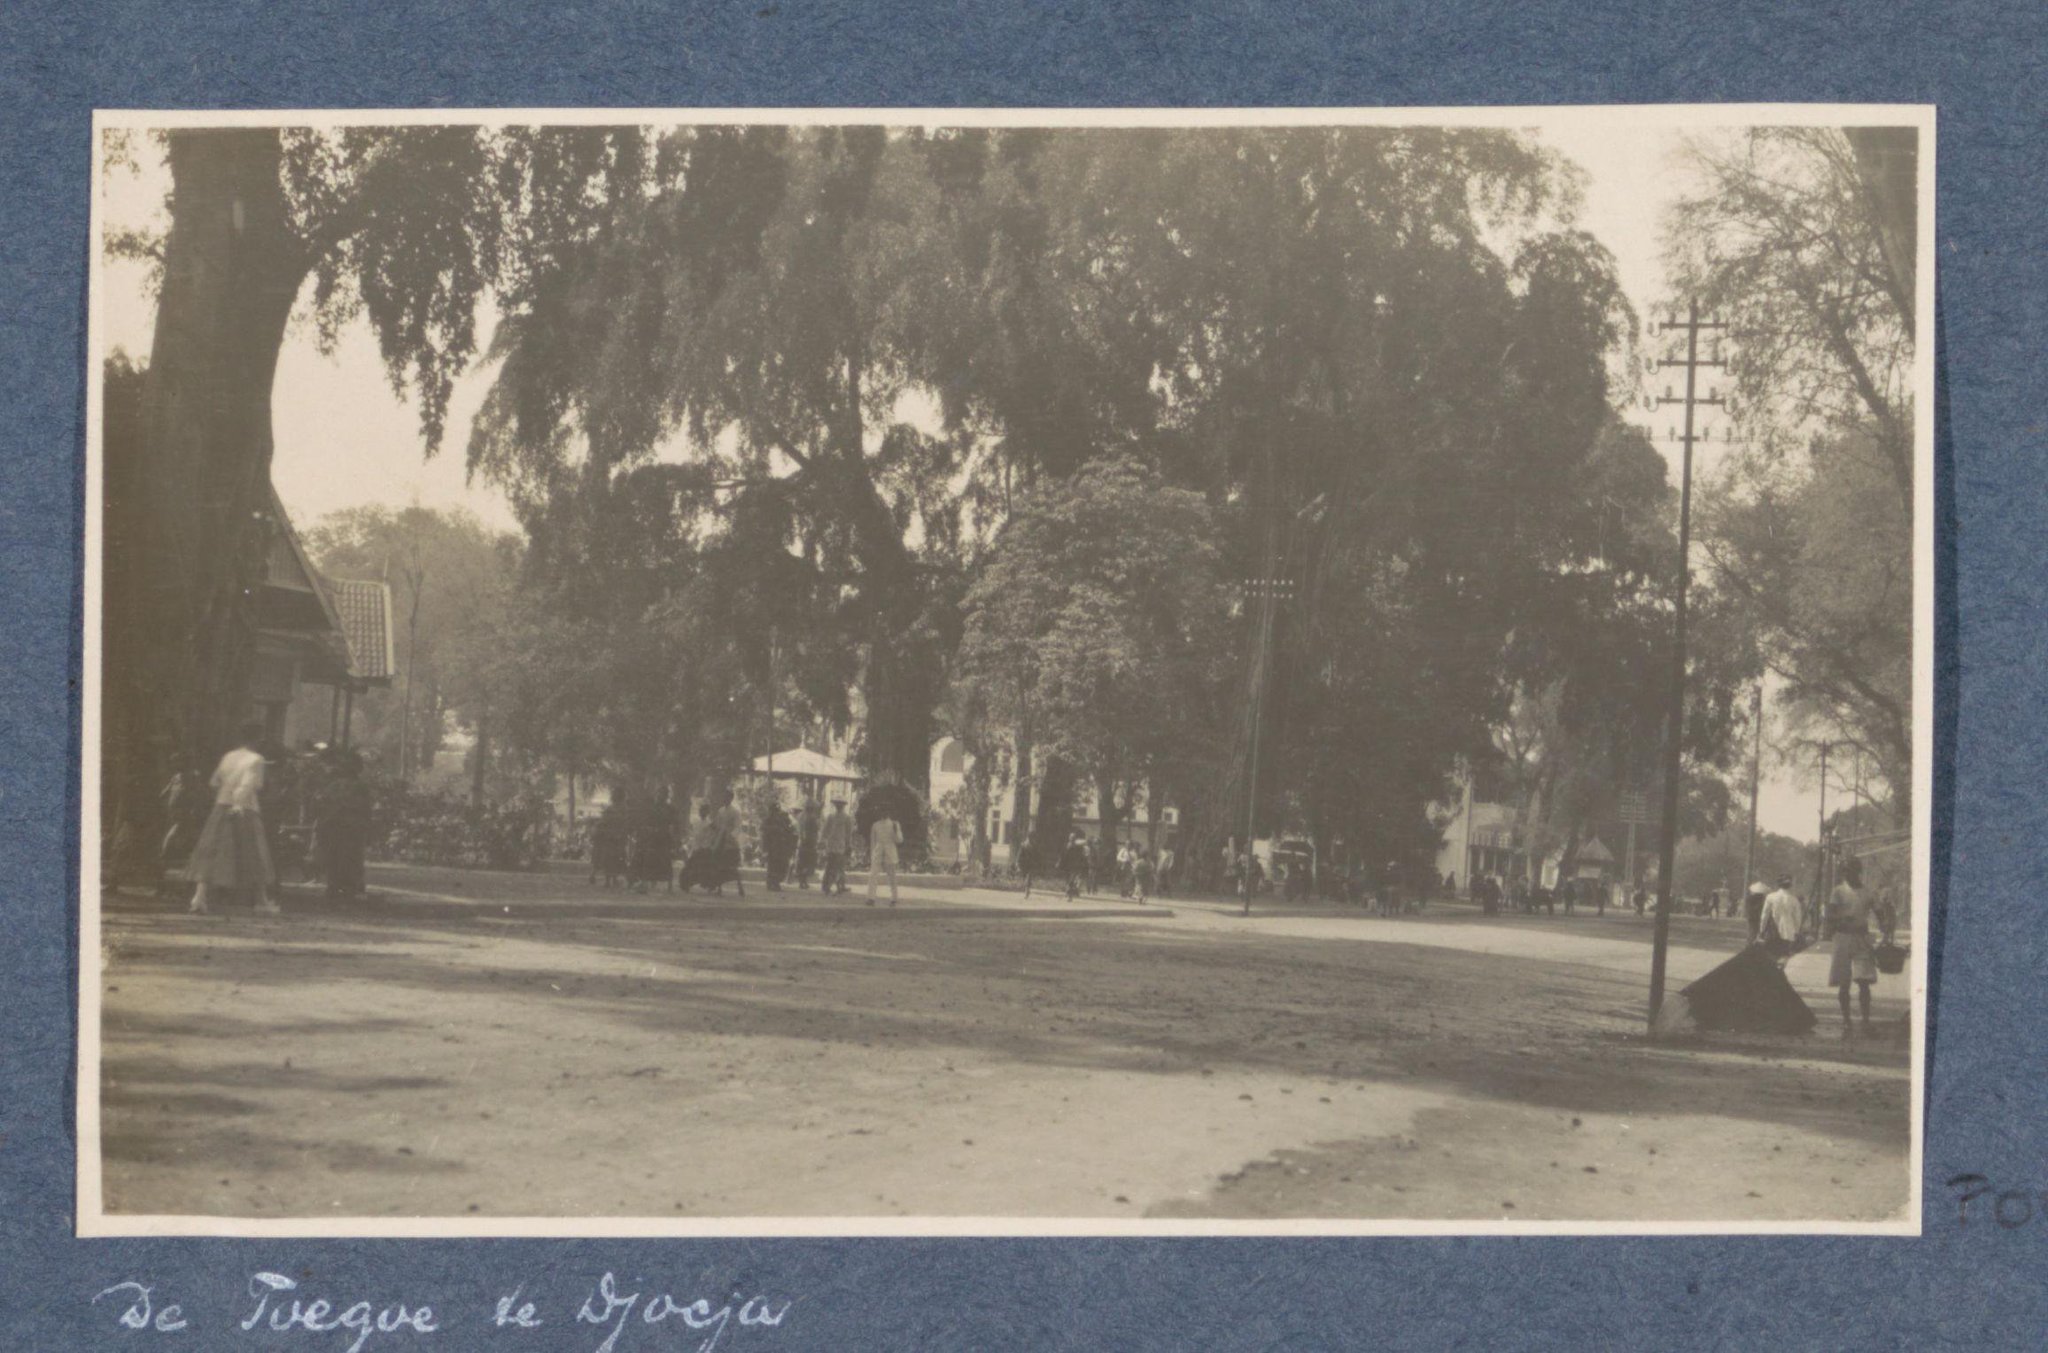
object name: album leaf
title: Toegoestraat te Jogyakarta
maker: Anonymous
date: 1900-1920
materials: paper, photographic support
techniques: gelatin silver print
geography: jogjakarta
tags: street (+ city(-scape) with figures, staffage)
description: Onderdeel van reisalbum met foto's van bedrijvigheid en bezienswaardigheden op Sumatra en Java en van de reis naar en van Nederlands-Indië.